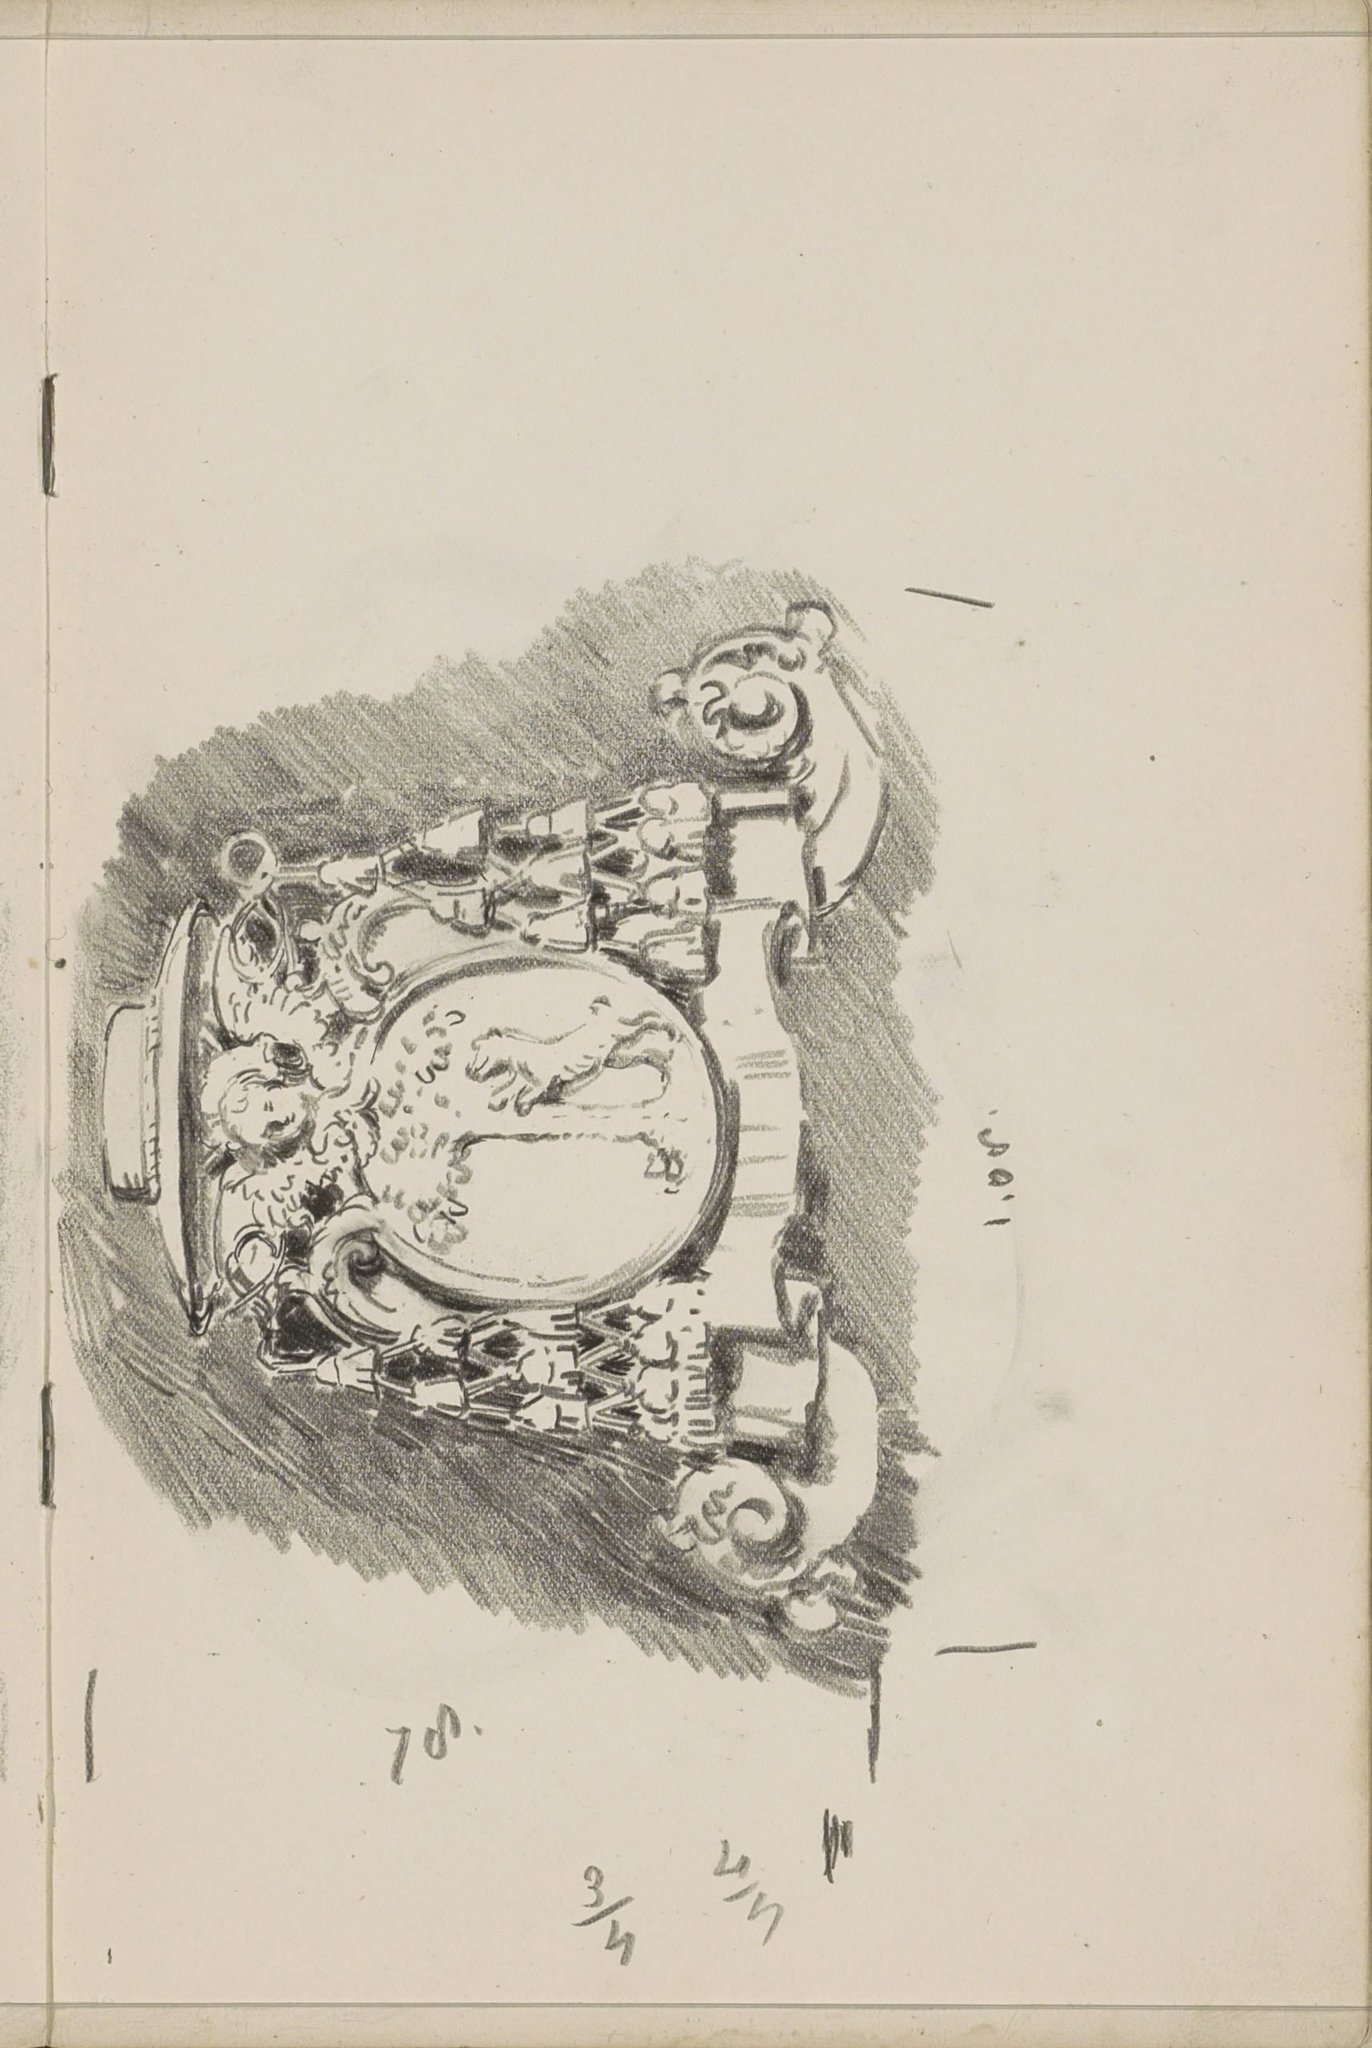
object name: sketchbook leaf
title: Ornament, mogelijk een wapen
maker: cornelis vreedenburgh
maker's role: draughtsman, print maker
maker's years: 1880-1946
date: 1890-1946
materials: chalk, paper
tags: coat of arms (as symbol of the state, etc.)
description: Medaillon met een voorstelling van een dier bij een boom in een met rolwerk versierd ornament. Blad 8 recto uit een schetsboek met 47 bladen.